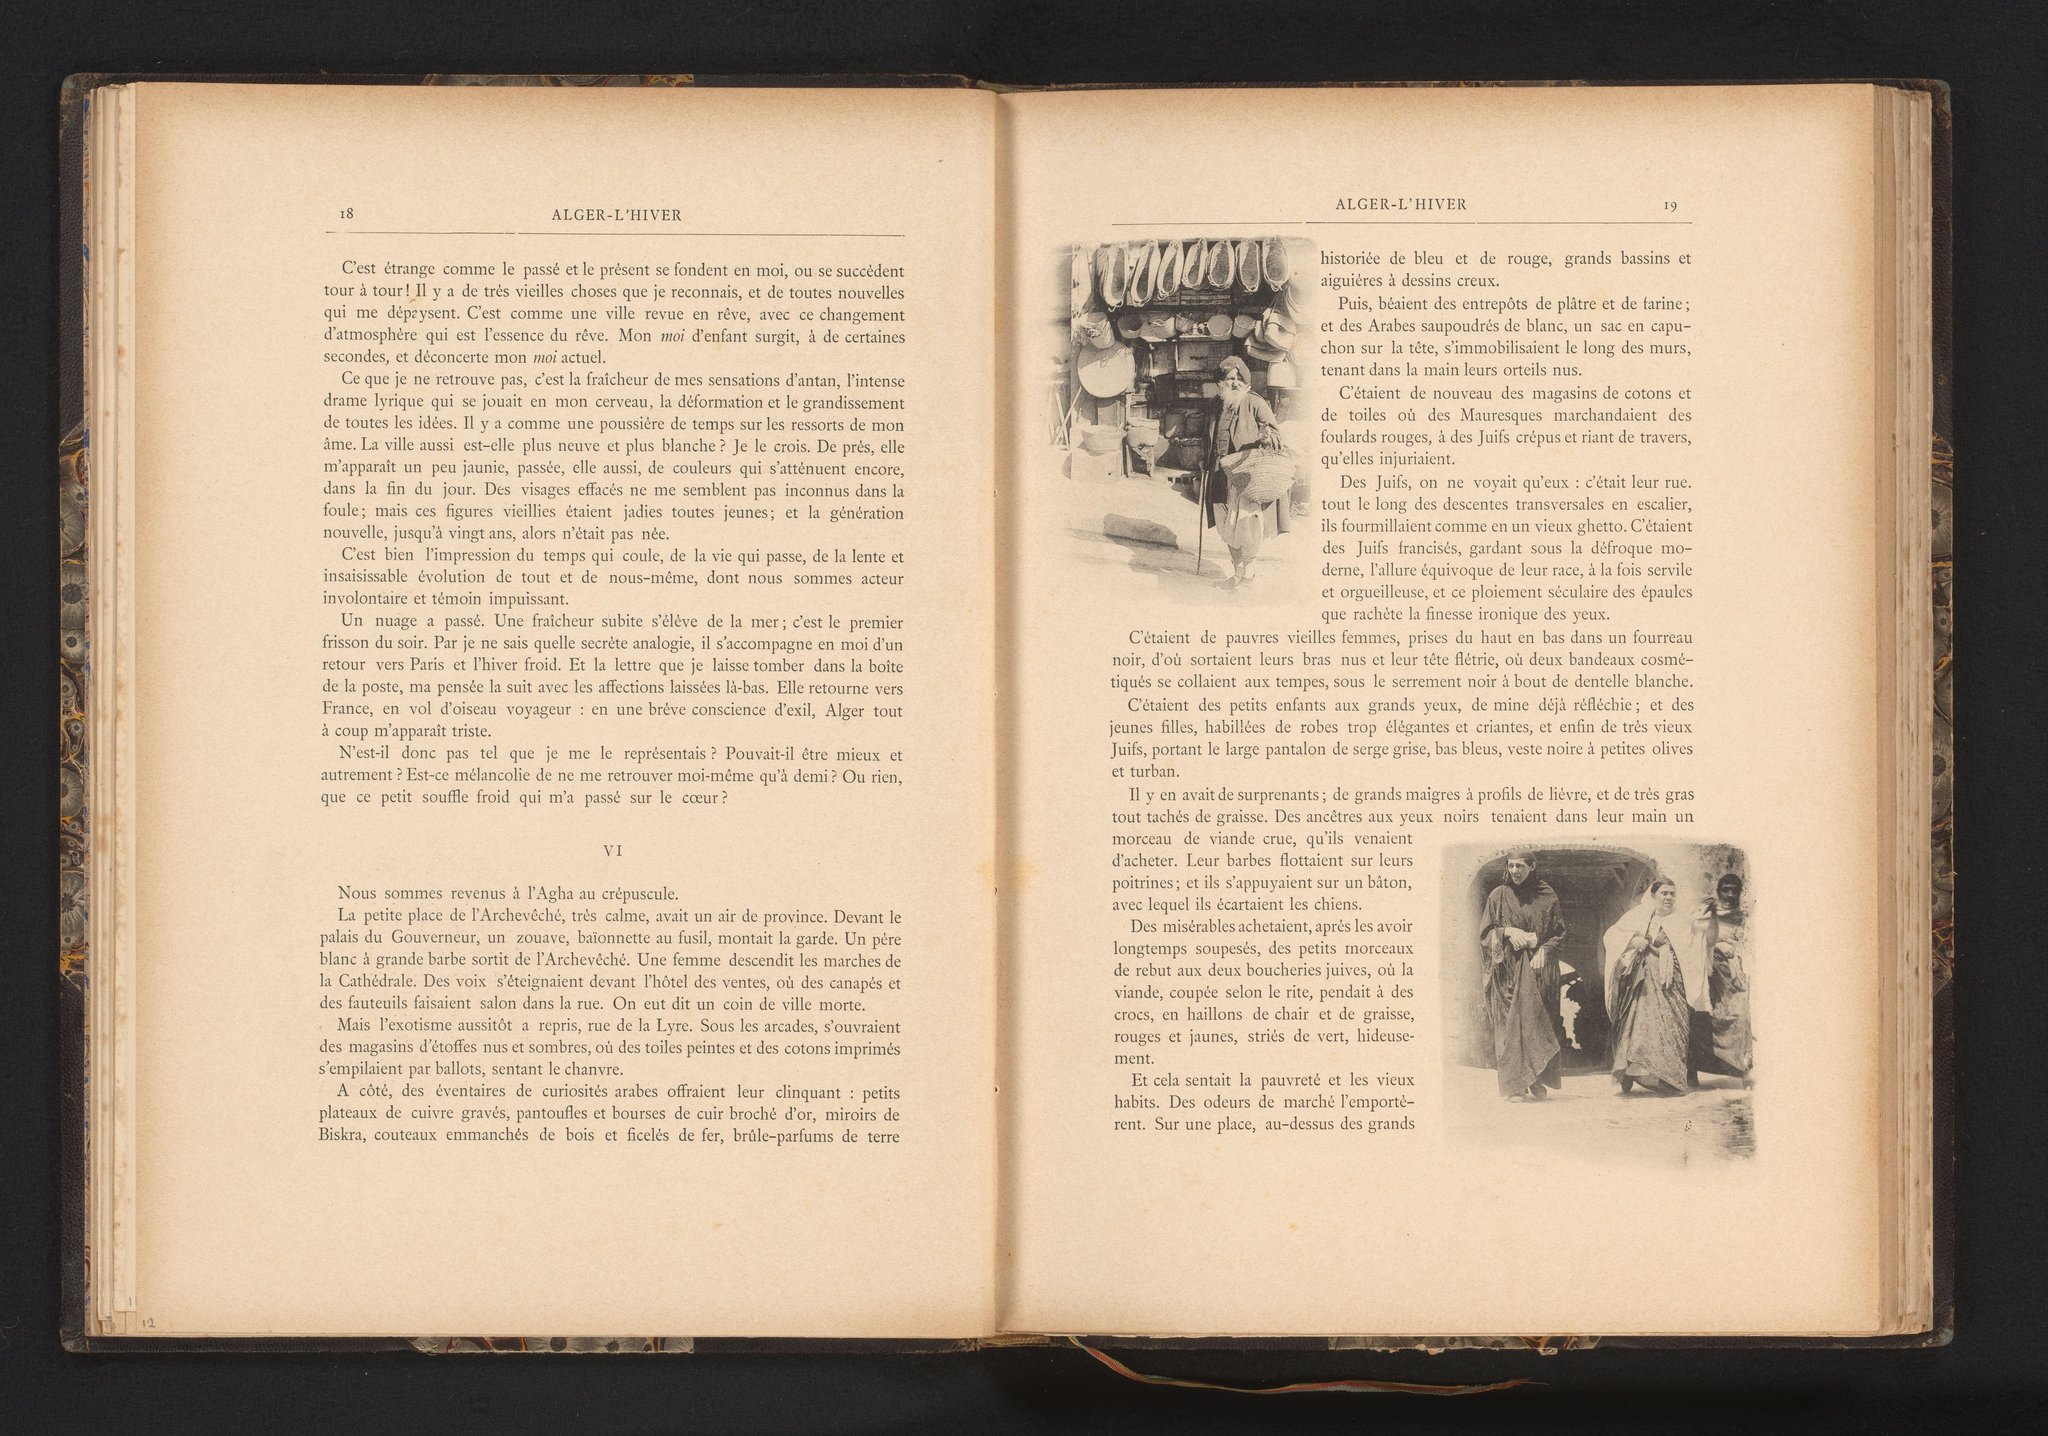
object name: photomechanical print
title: Man met een mand en een wandelstok op een markt in Algiers, Algerije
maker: jules gervais-courtellemont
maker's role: fotograaf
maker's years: 1863-1931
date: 1888-1893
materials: paper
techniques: photograph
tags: adult man, container made of plant material other than wood: basket, market